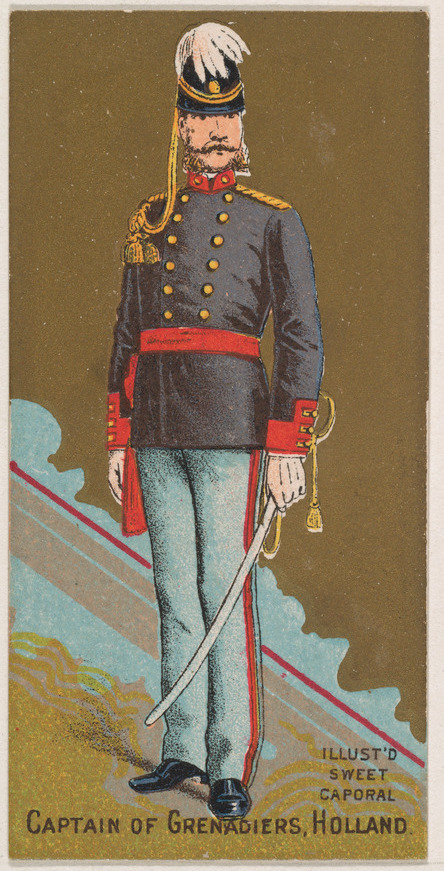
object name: print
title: Captain of Grenadiers, Holland, from the Military Series (N224) issued by Kinney Tobacco Company to promote Sweet Caporal Cigarettes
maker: kinney brothers tobacco company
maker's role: publisher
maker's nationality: american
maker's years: 1869-2011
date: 1888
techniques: color lithograph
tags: soldiers,men